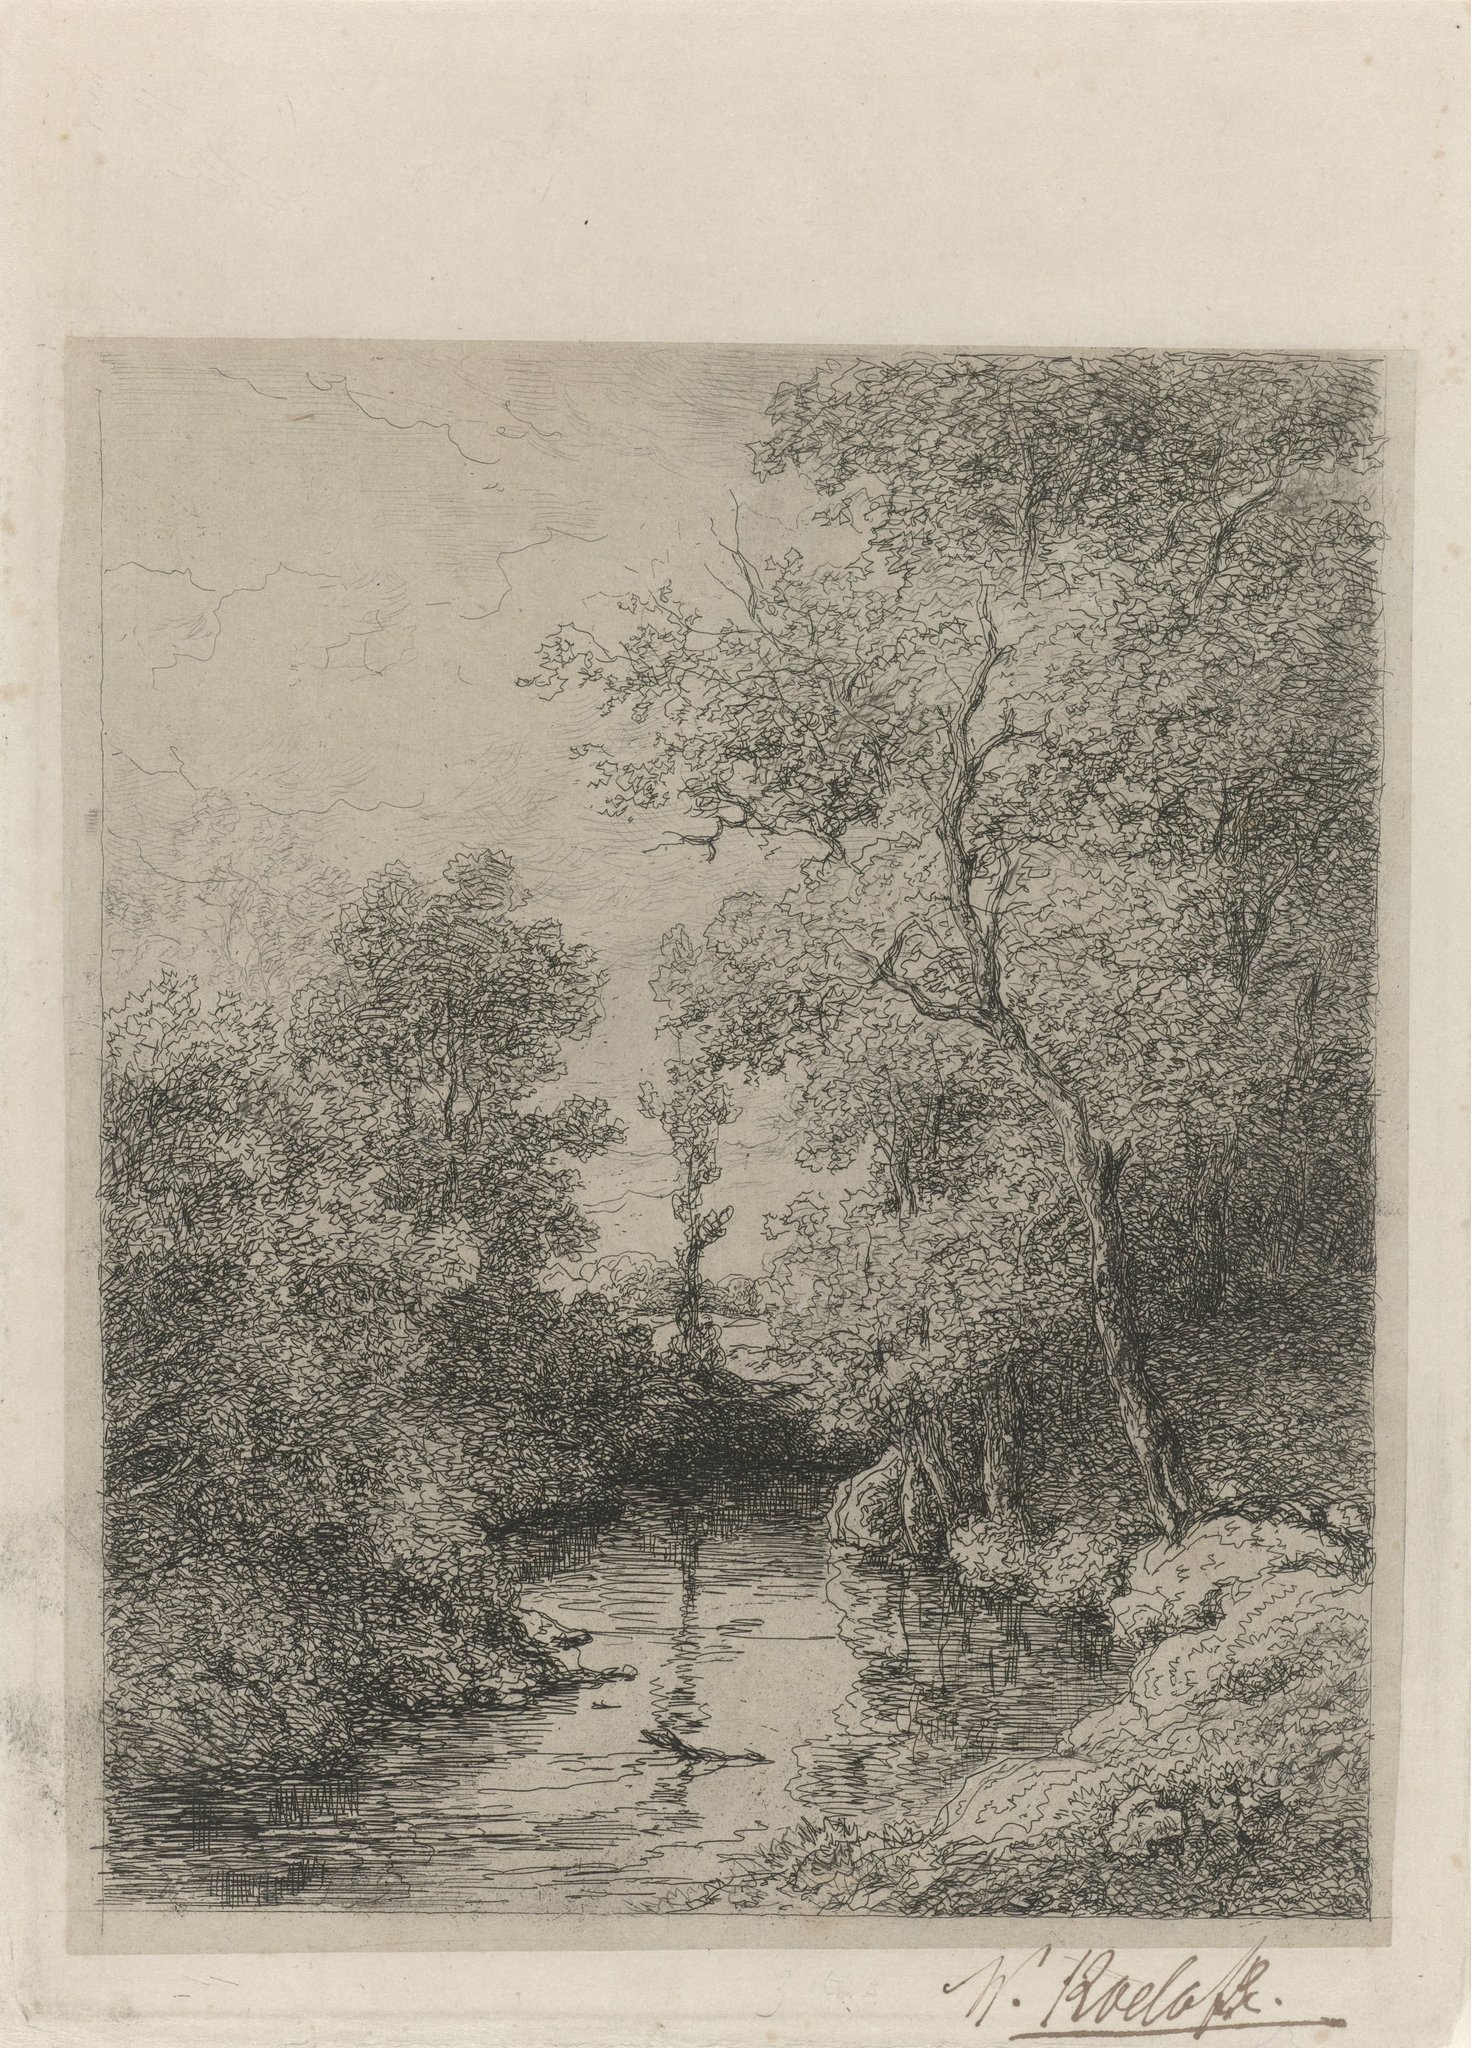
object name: print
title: Kreek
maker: willem roelofs (i)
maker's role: draughtsman, painter, print maker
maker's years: 1822-1897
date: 1832-1893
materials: paper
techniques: etching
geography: netherlands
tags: plants; vegetation, trees, brook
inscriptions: collector's mark: Lugt 2228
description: Gezicht op een kreek, omgeven door bomen en struiken.